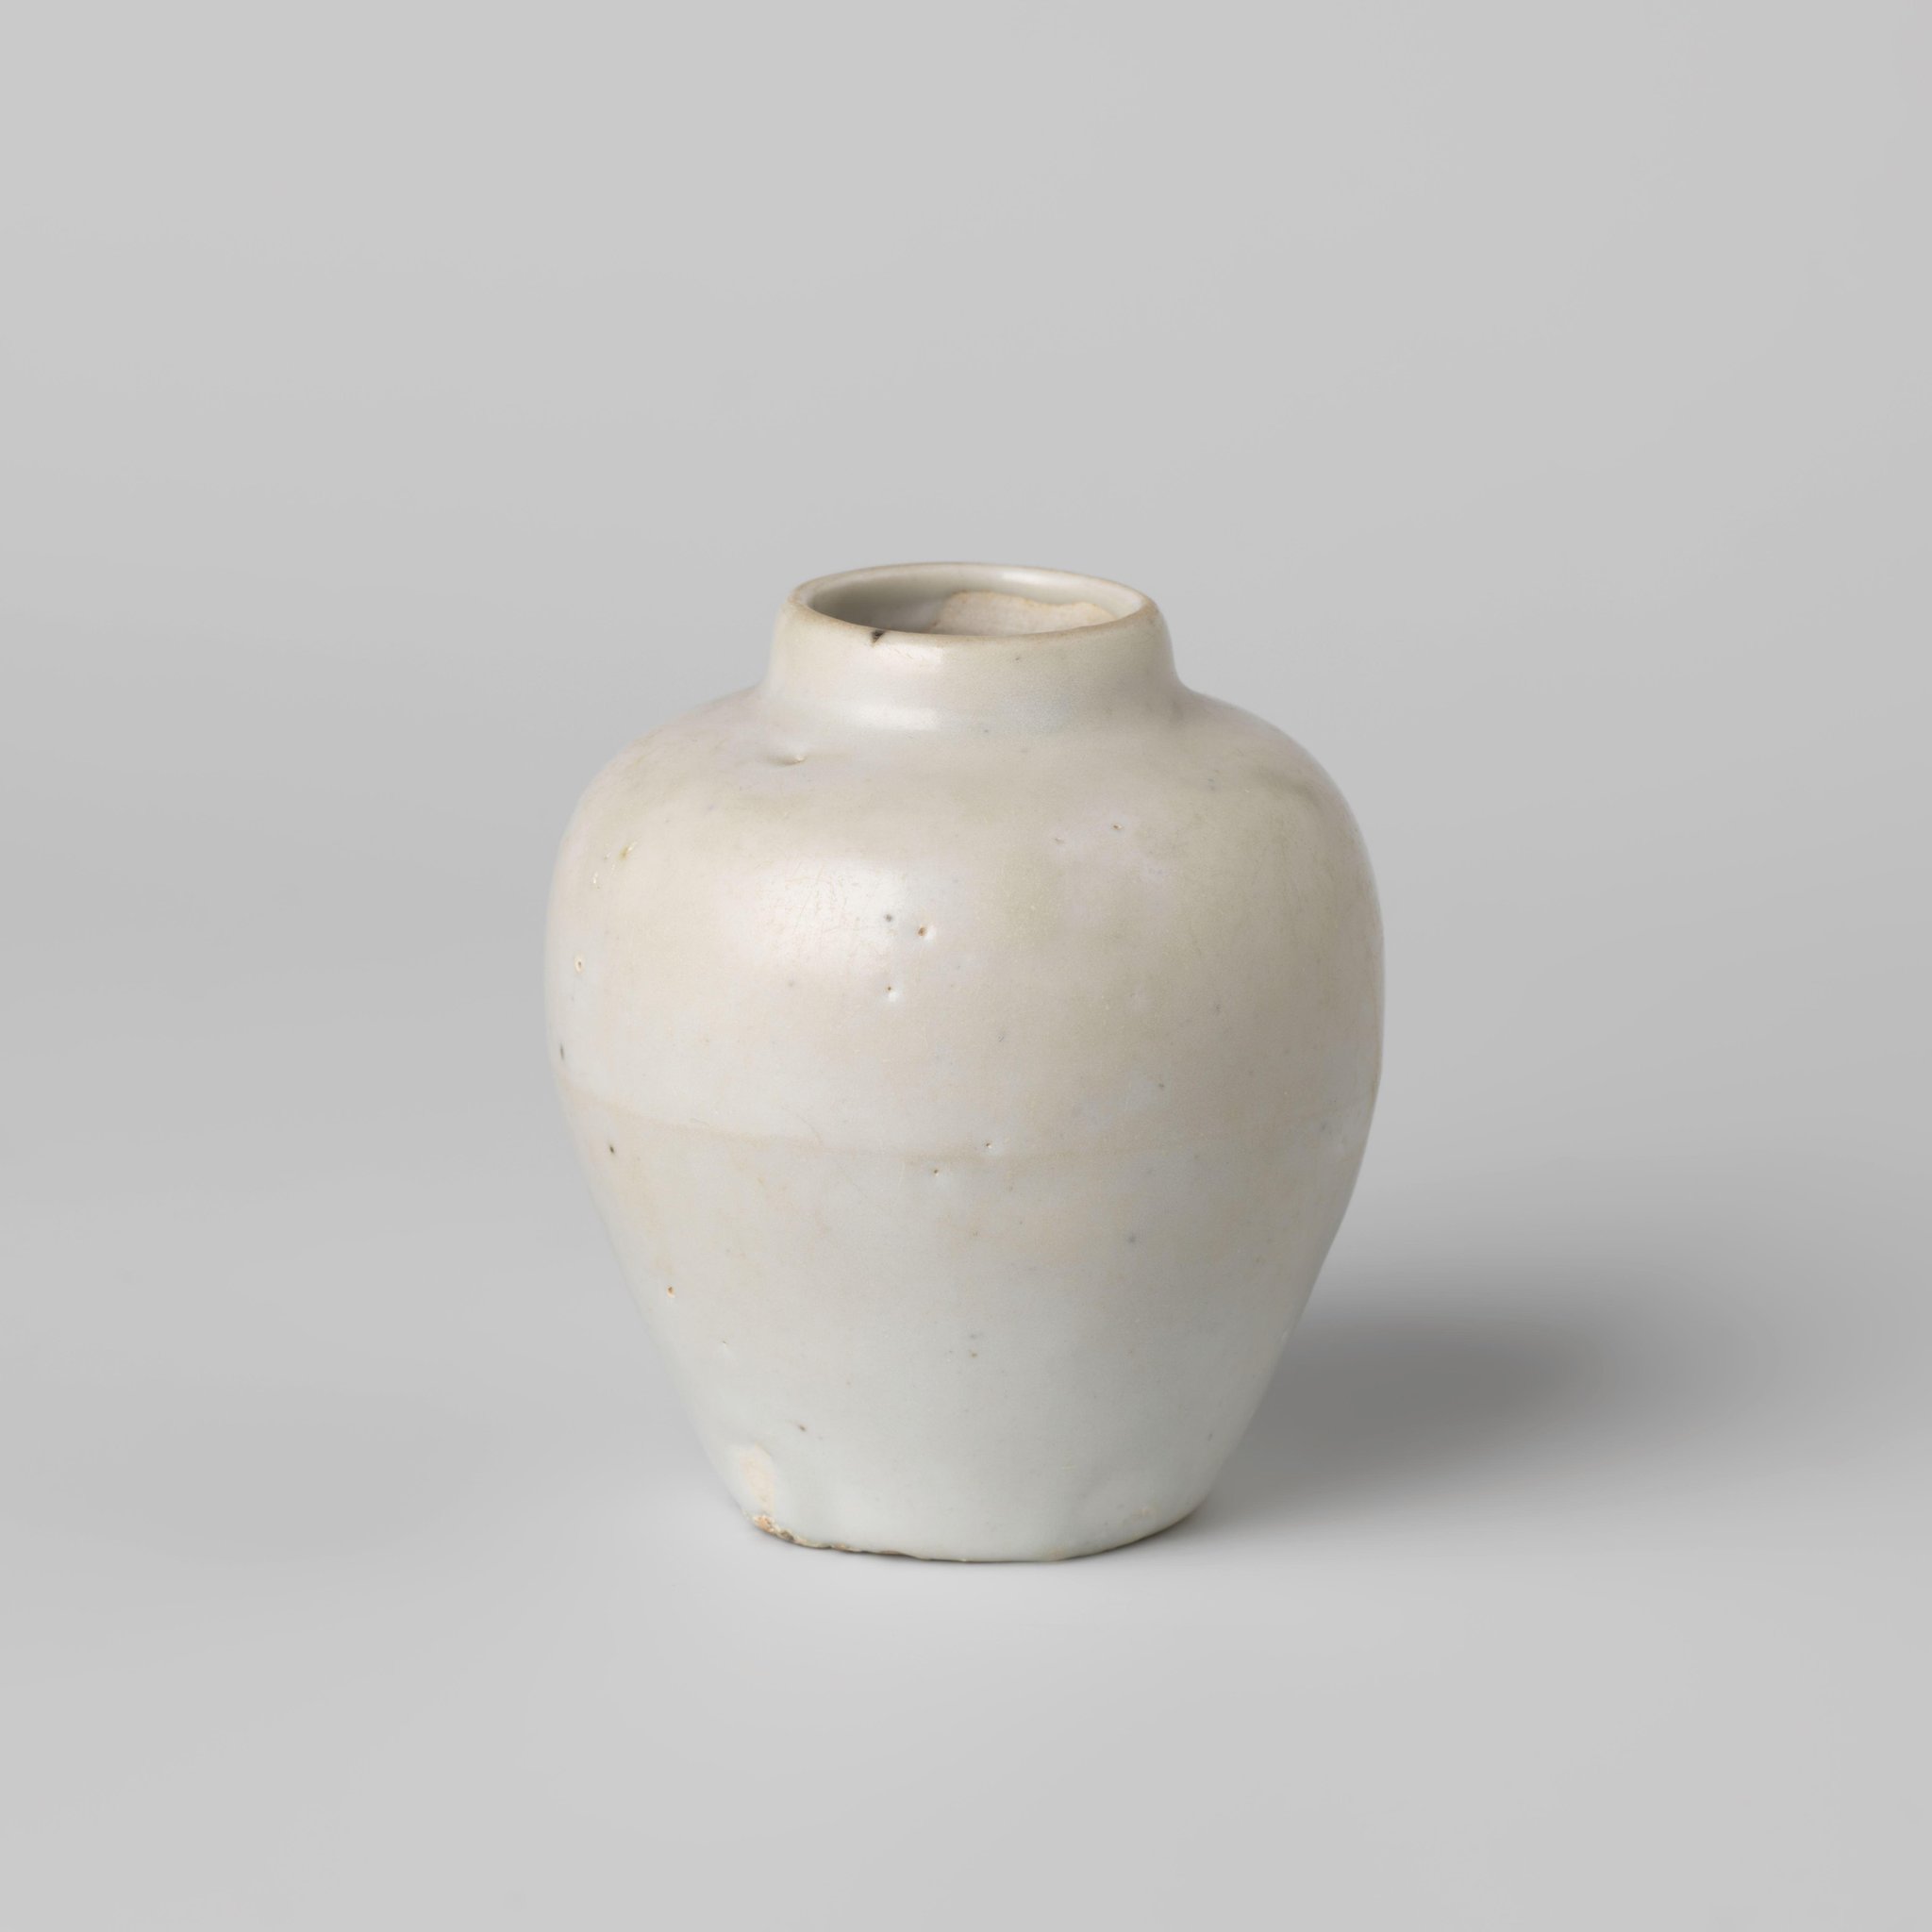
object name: vase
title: Ovoid vase with a white glaze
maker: Anonymous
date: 1500-1599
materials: glaze, porcelain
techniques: firing, turning, vitrification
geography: south china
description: Eivormige vaas van porselein met een platte, ongeglazuurde onderzijde en een korte nek, bedekt met een grijswit glazuur. Ming porselein.